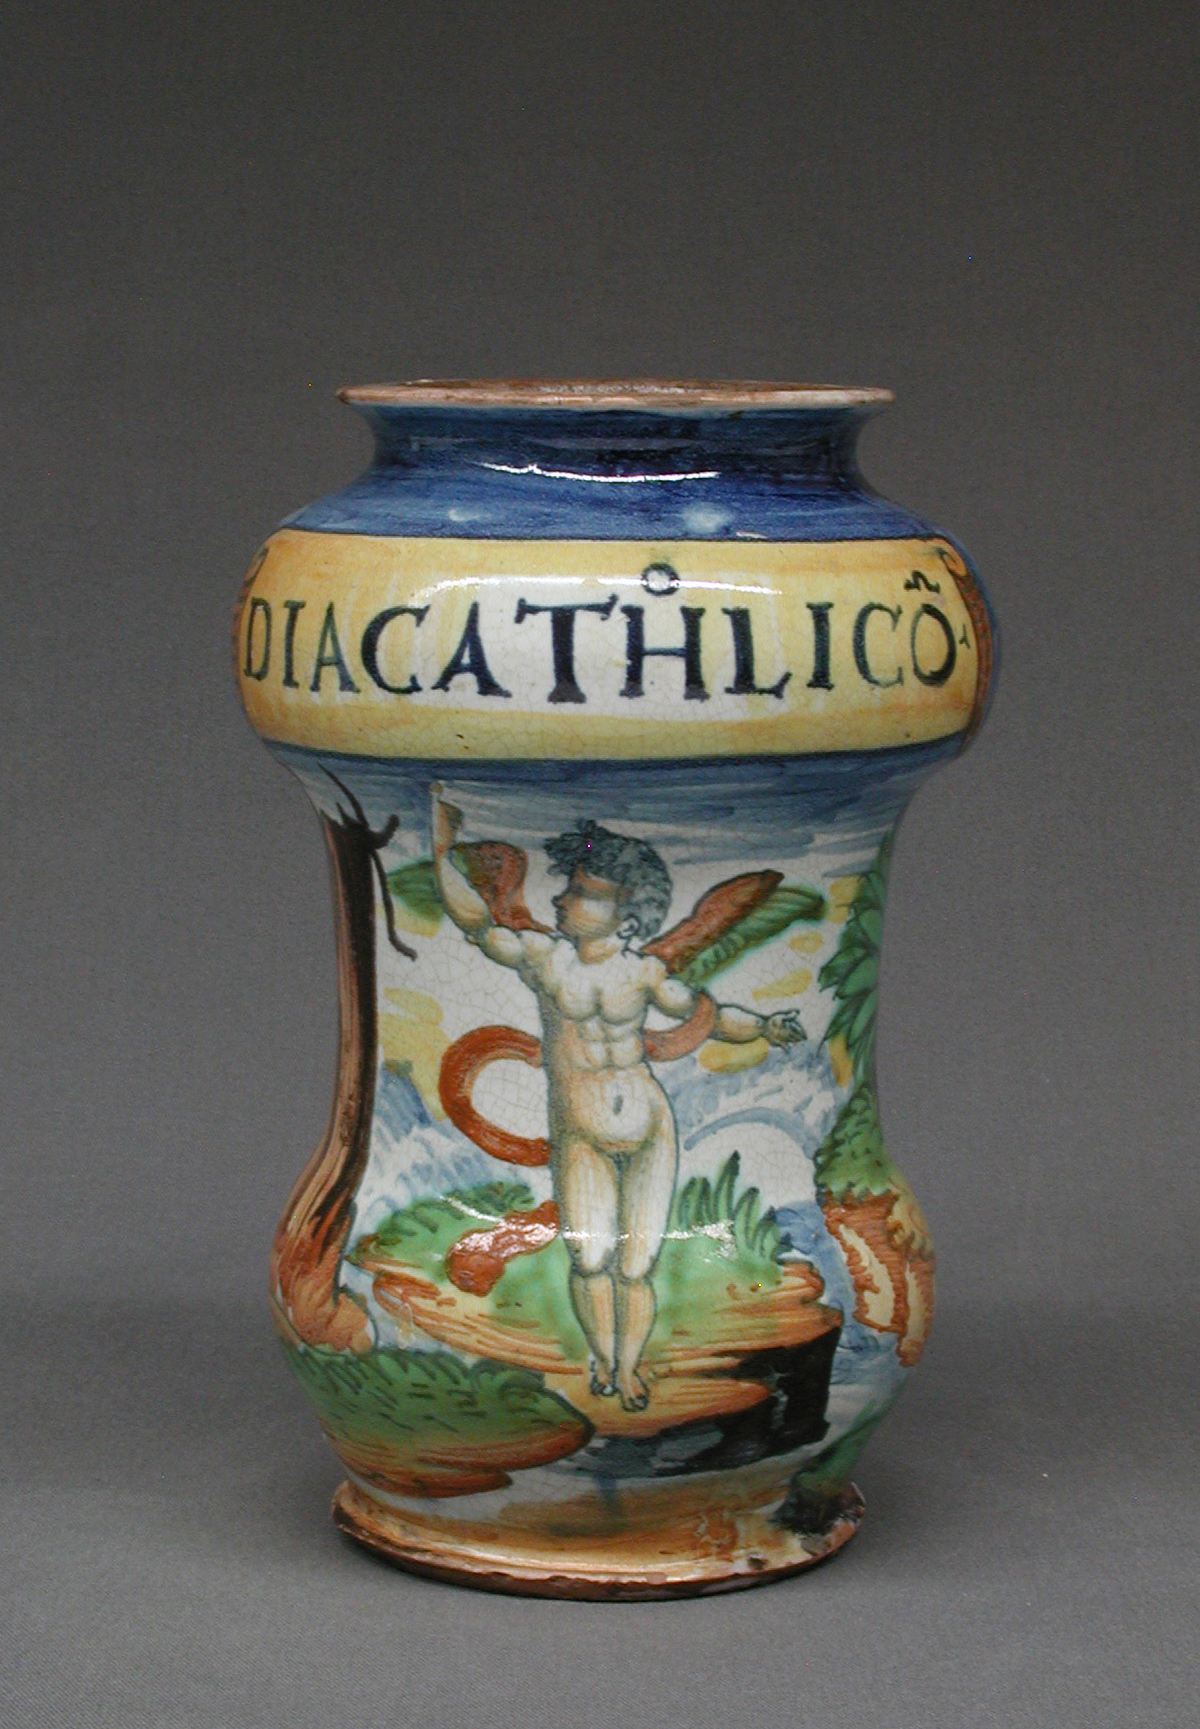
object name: albarello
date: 1600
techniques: maiolica, glazing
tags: angels